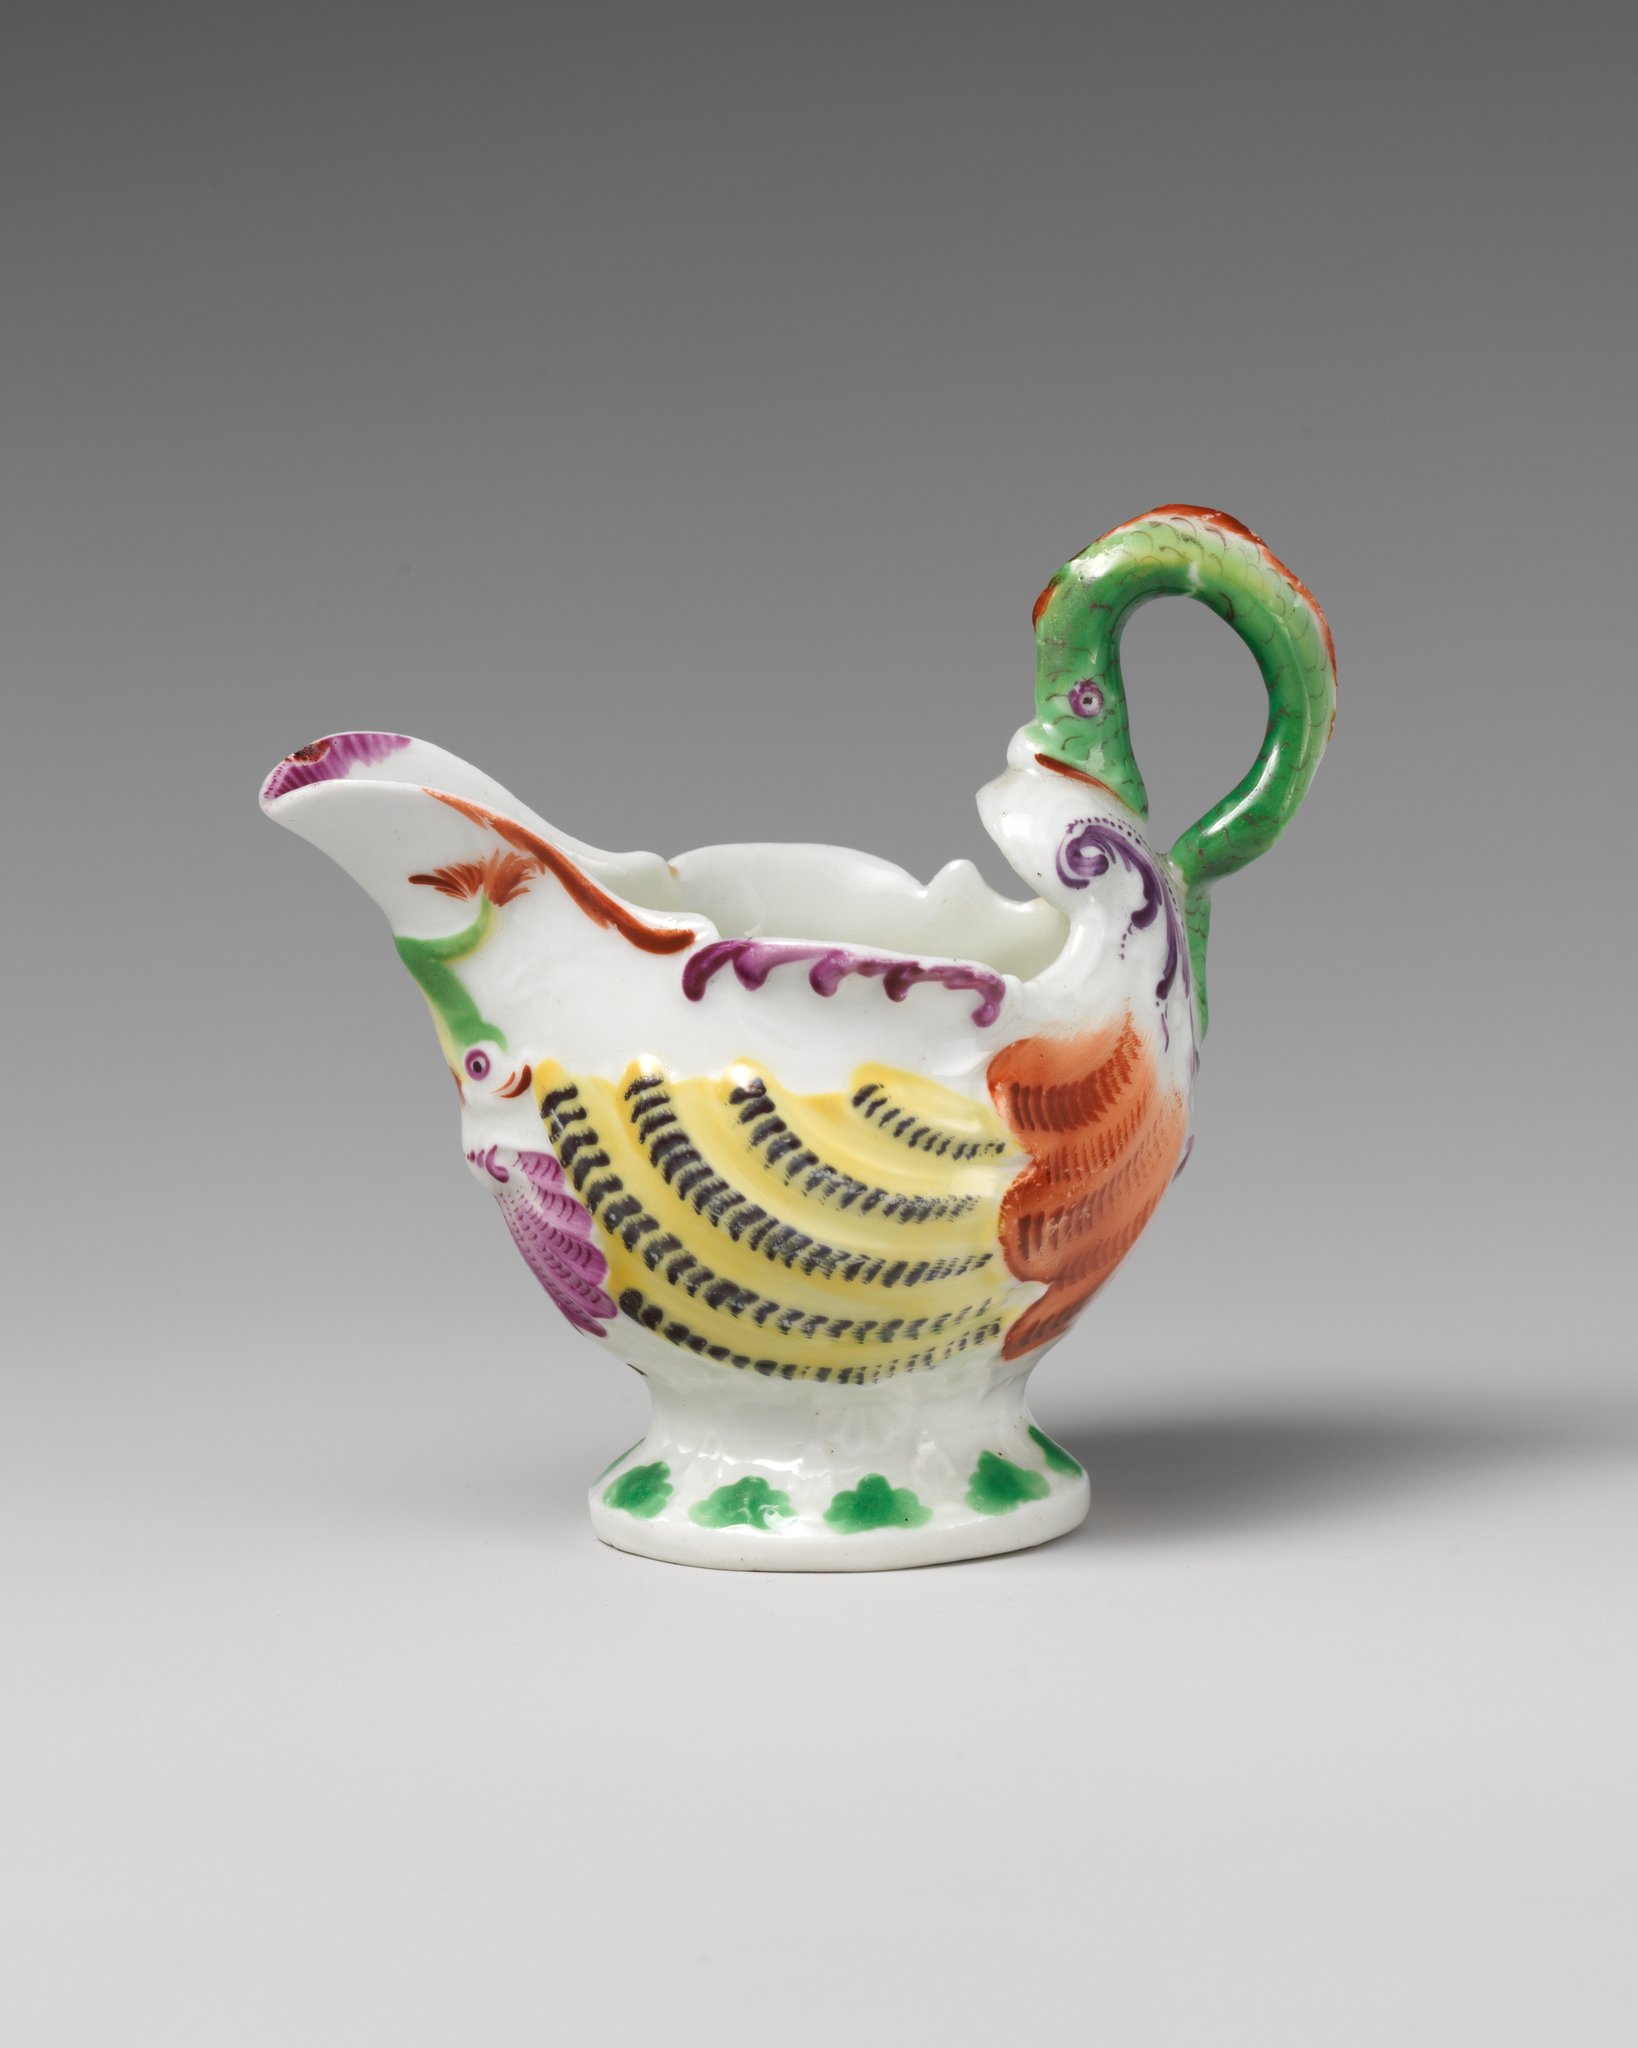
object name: cream jug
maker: worcester factory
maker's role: factory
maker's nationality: british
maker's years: 1751-2008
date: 1765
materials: soft paste porcelain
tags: birds